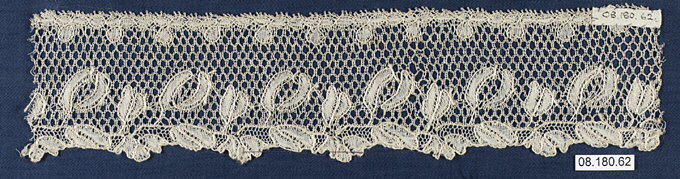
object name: fragment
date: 1801-1900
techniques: lace